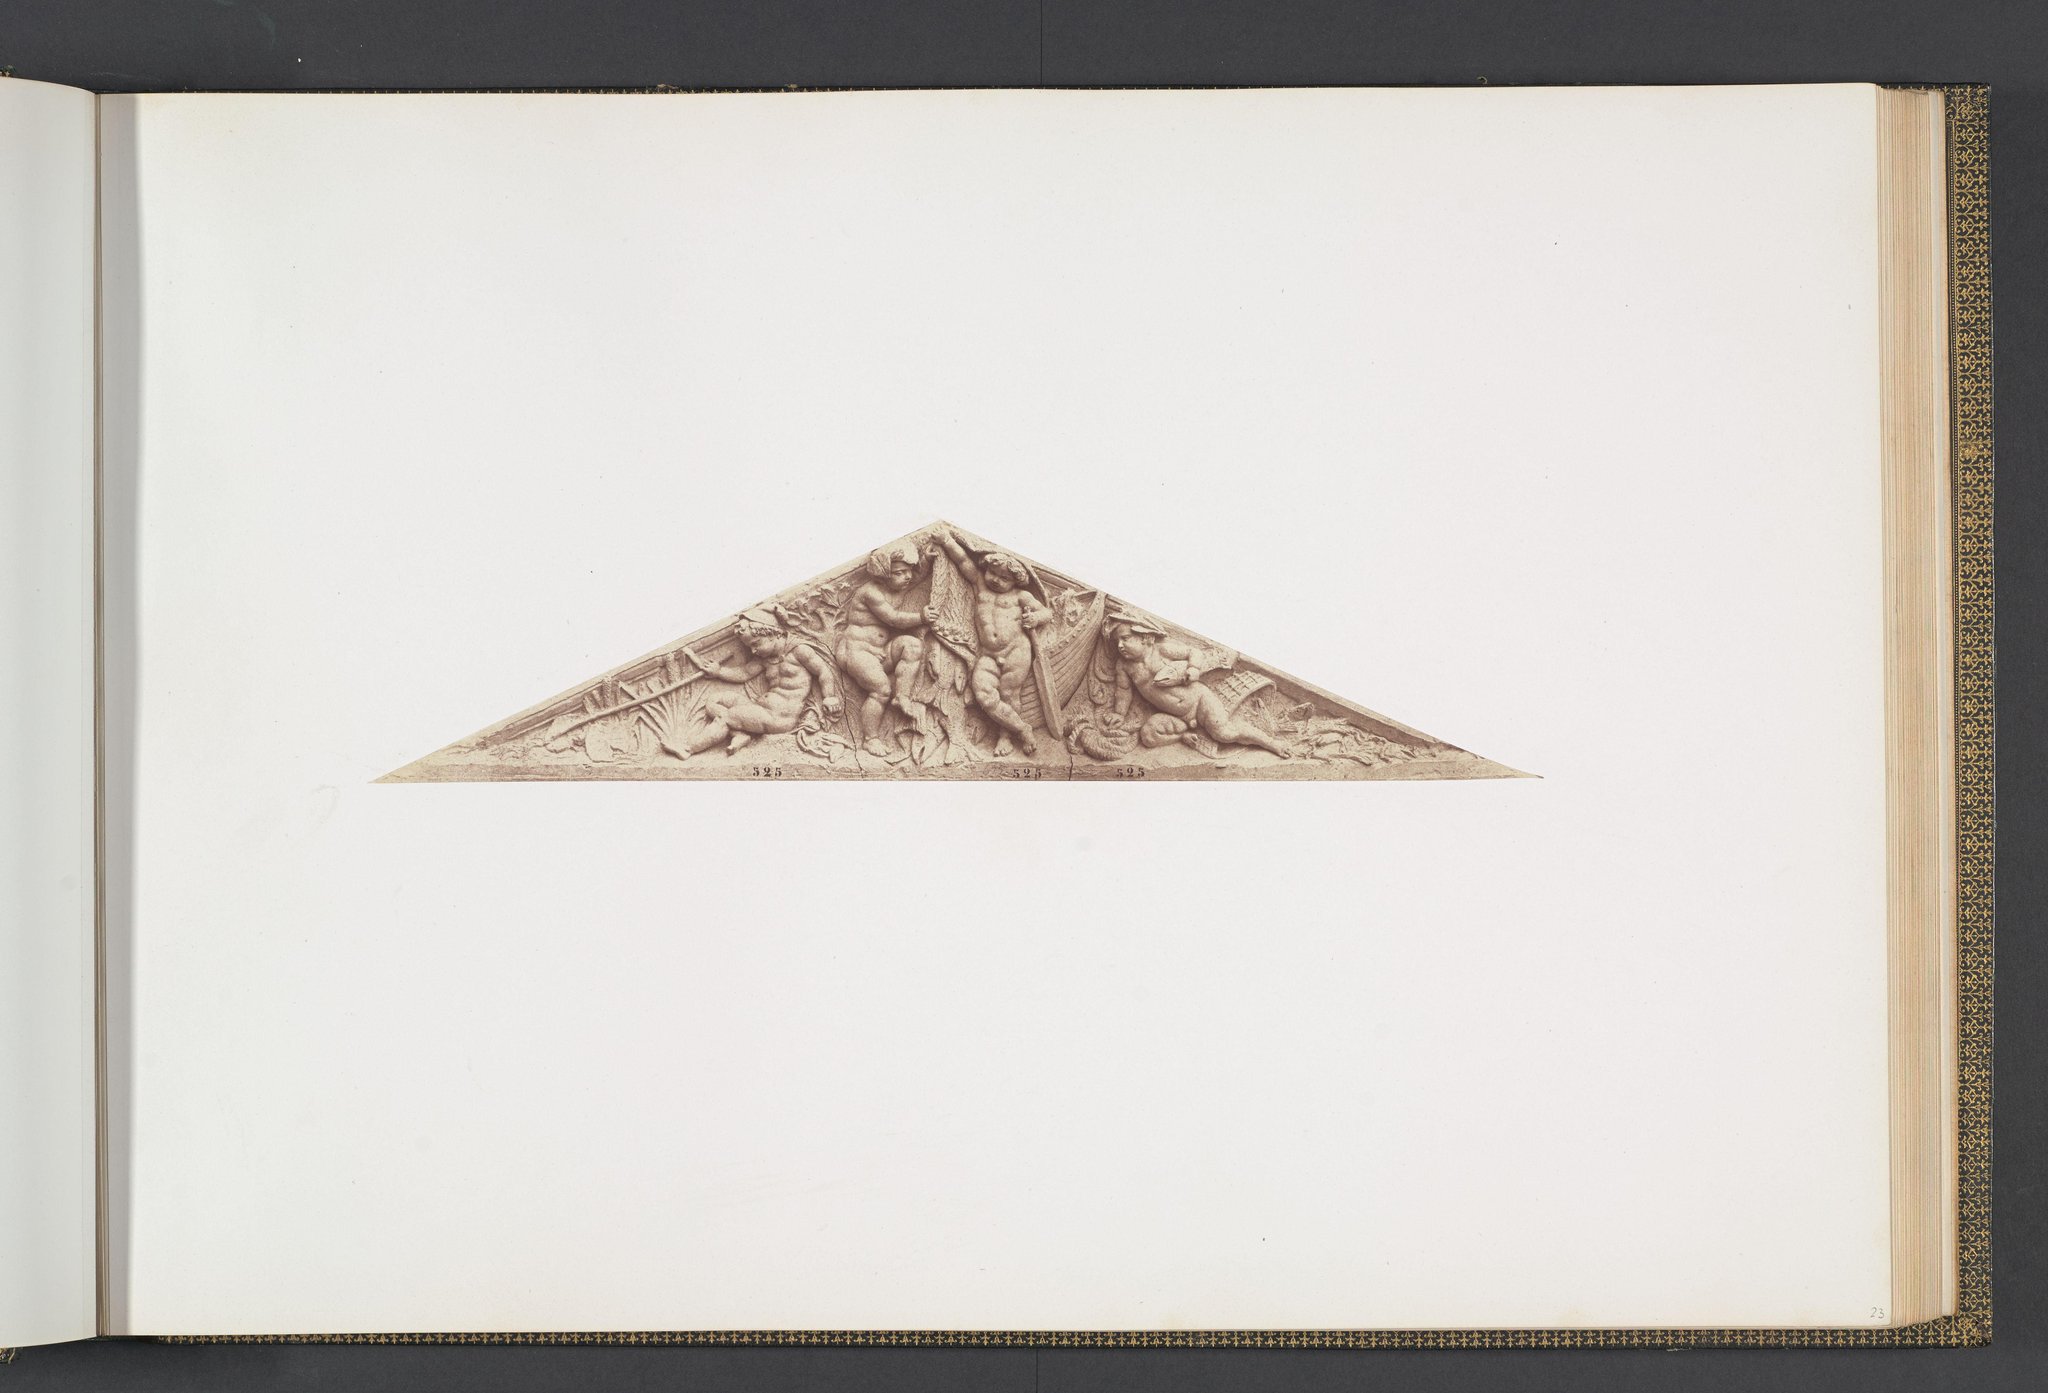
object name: album leaf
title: Gipsmodellen voor beeldhouwwerken op het Palais du Louvre: "La Pêche" door François Truphème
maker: édouard denis baldus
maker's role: fotograaf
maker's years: 1813-1889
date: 1855-1857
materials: paper, photographic support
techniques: salted paper print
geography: paris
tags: other architectural details (with name), permanent exhibition, museum, paris, tuileries palace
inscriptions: number: ‘525’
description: Onderdeel van Réunion des Tuileries au Louvre 1852-1857, album 3.